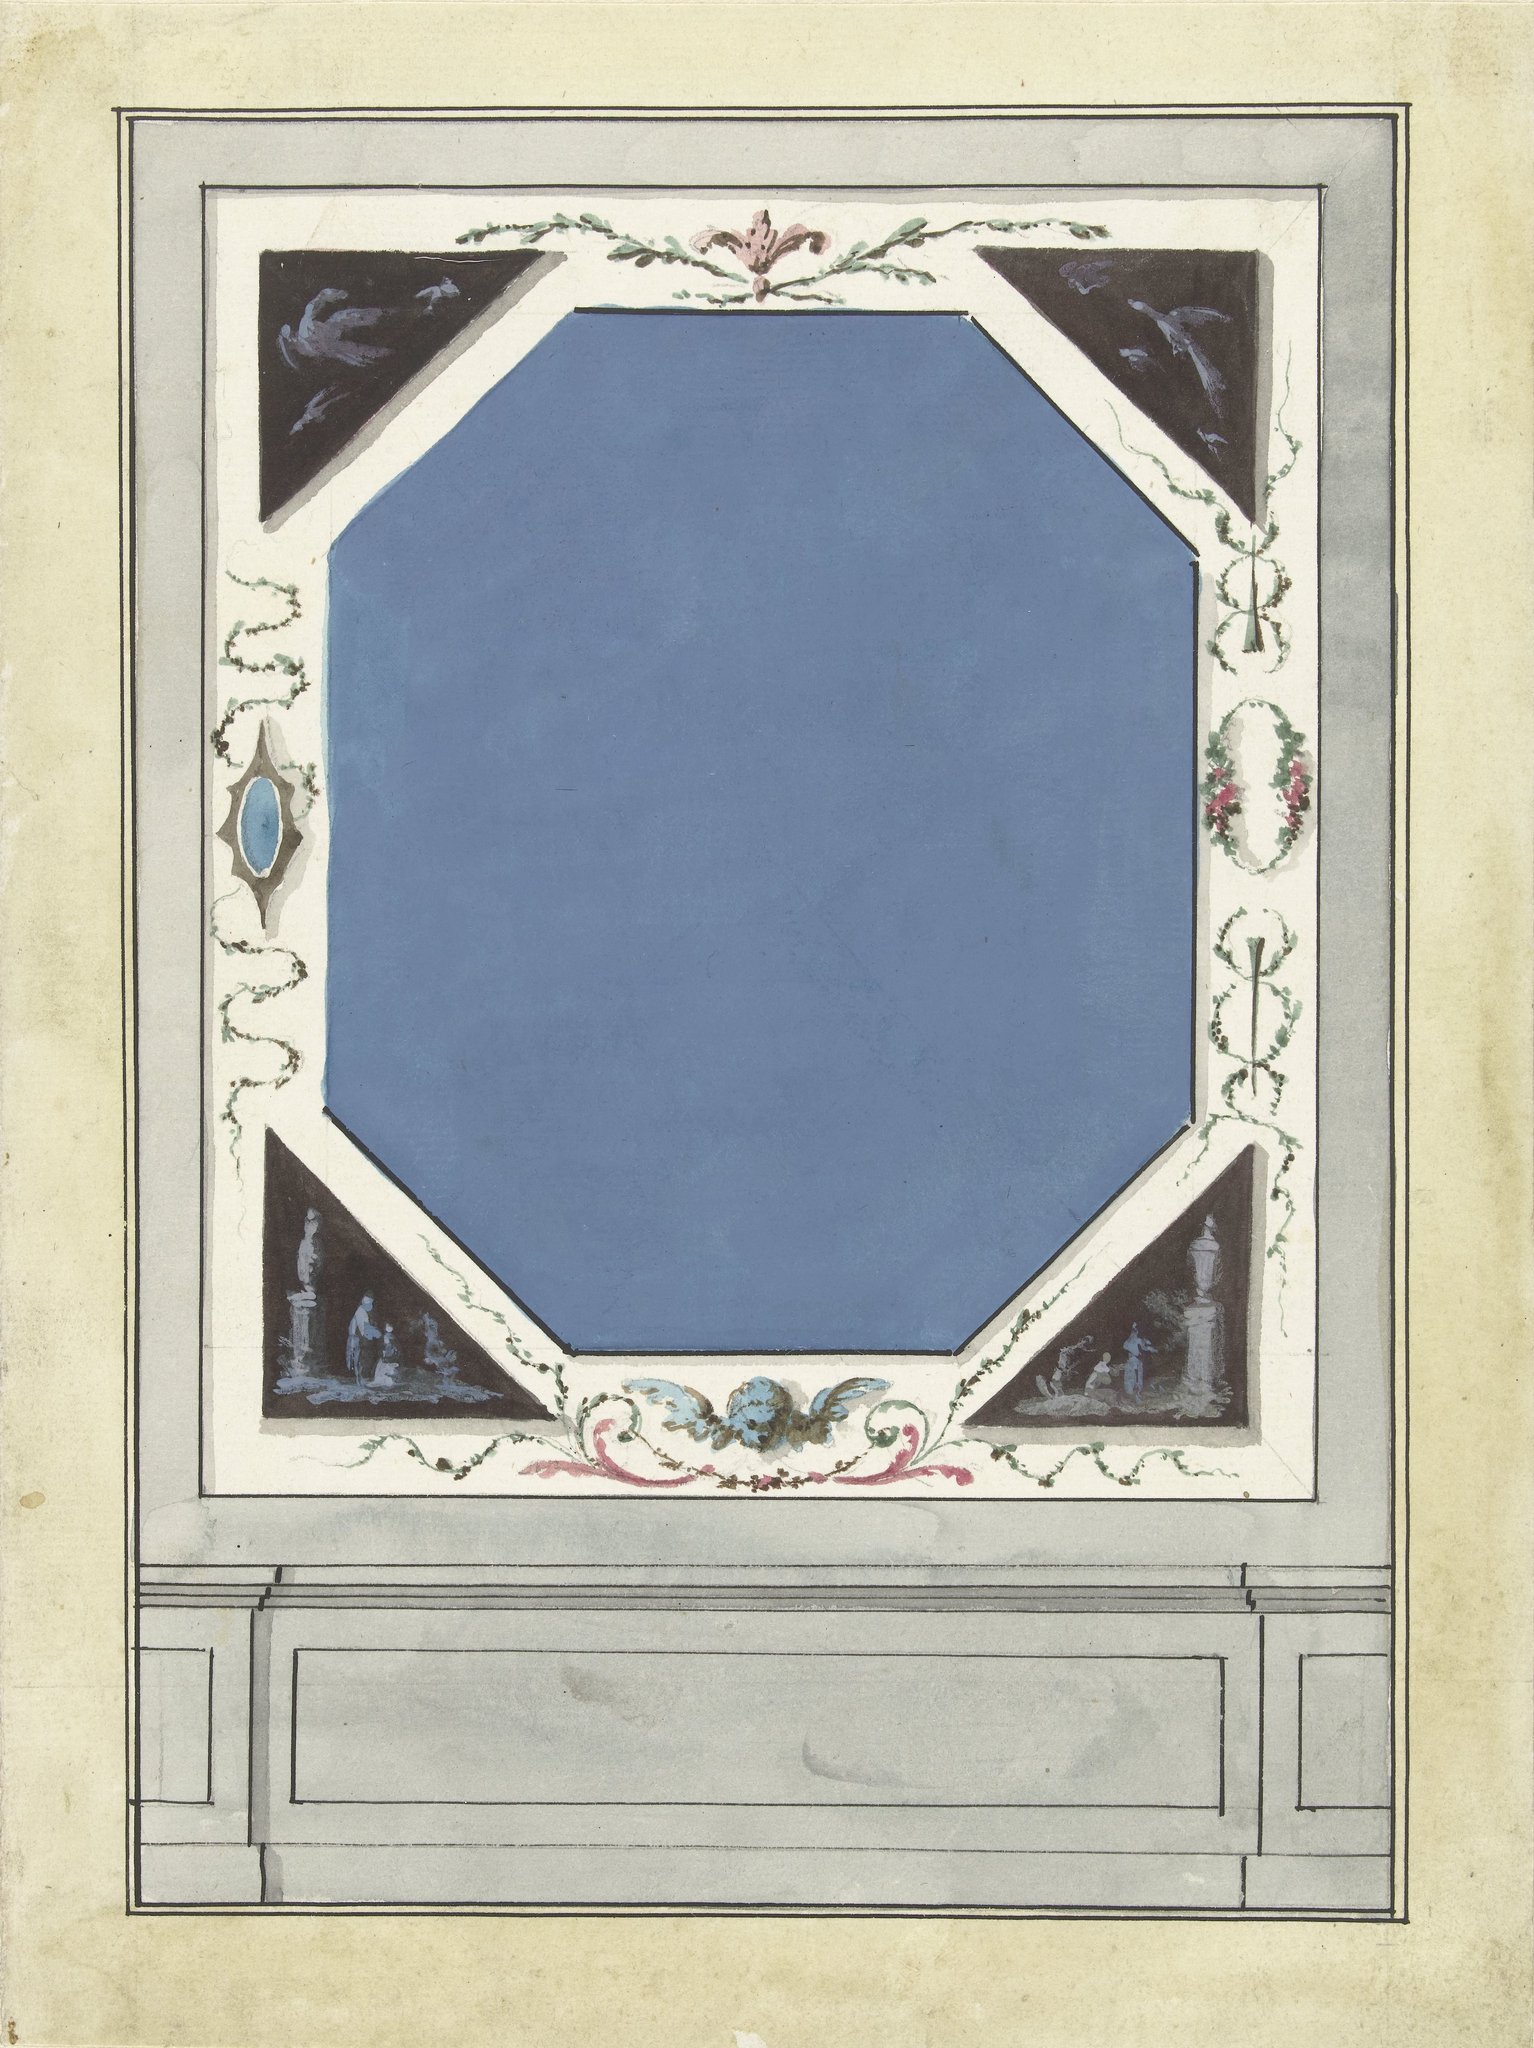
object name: design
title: Ontwerp voor kamerversiering met een paneel met centraal een blauwe achthoek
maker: abraham meertens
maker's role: draughtsman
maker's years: 1757-1823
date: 1767-1823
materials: paint, ink, paper, pencil, watercolor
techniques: brush, pen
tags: wall-covering